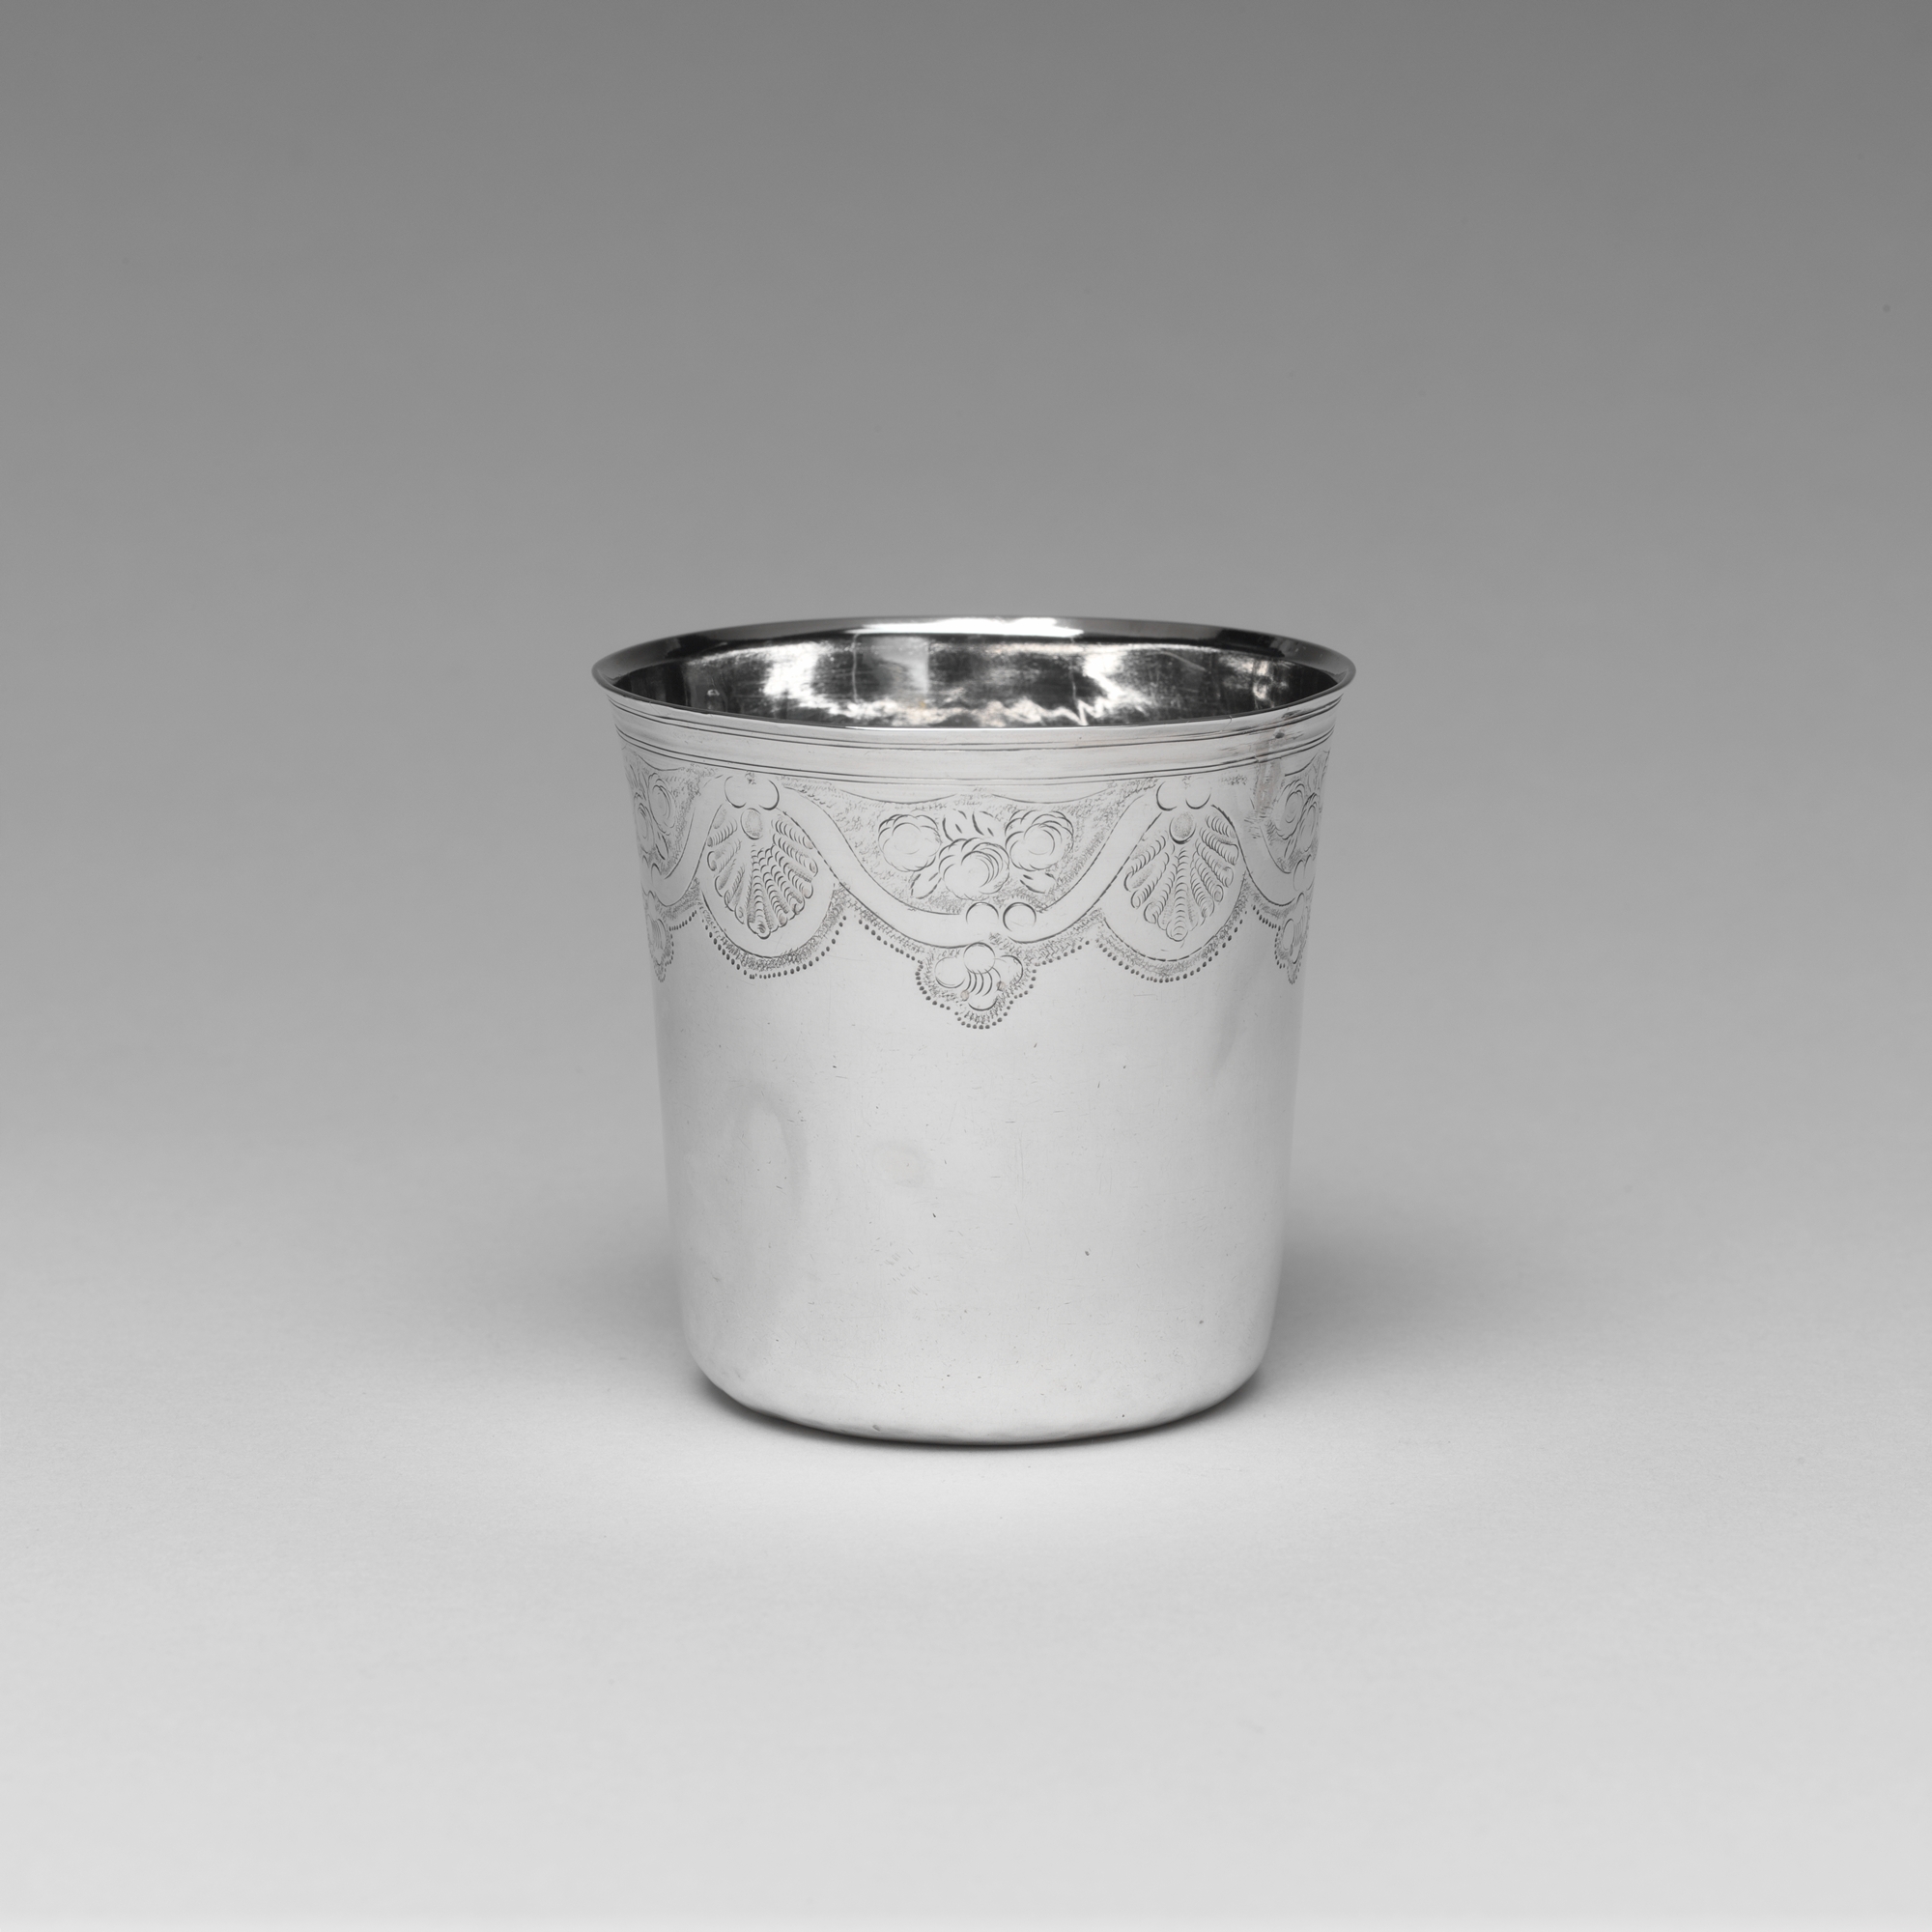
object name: tumbler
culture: french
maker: denis colombier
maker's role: maker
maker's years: 1776-1806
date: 1789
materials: silver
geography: france